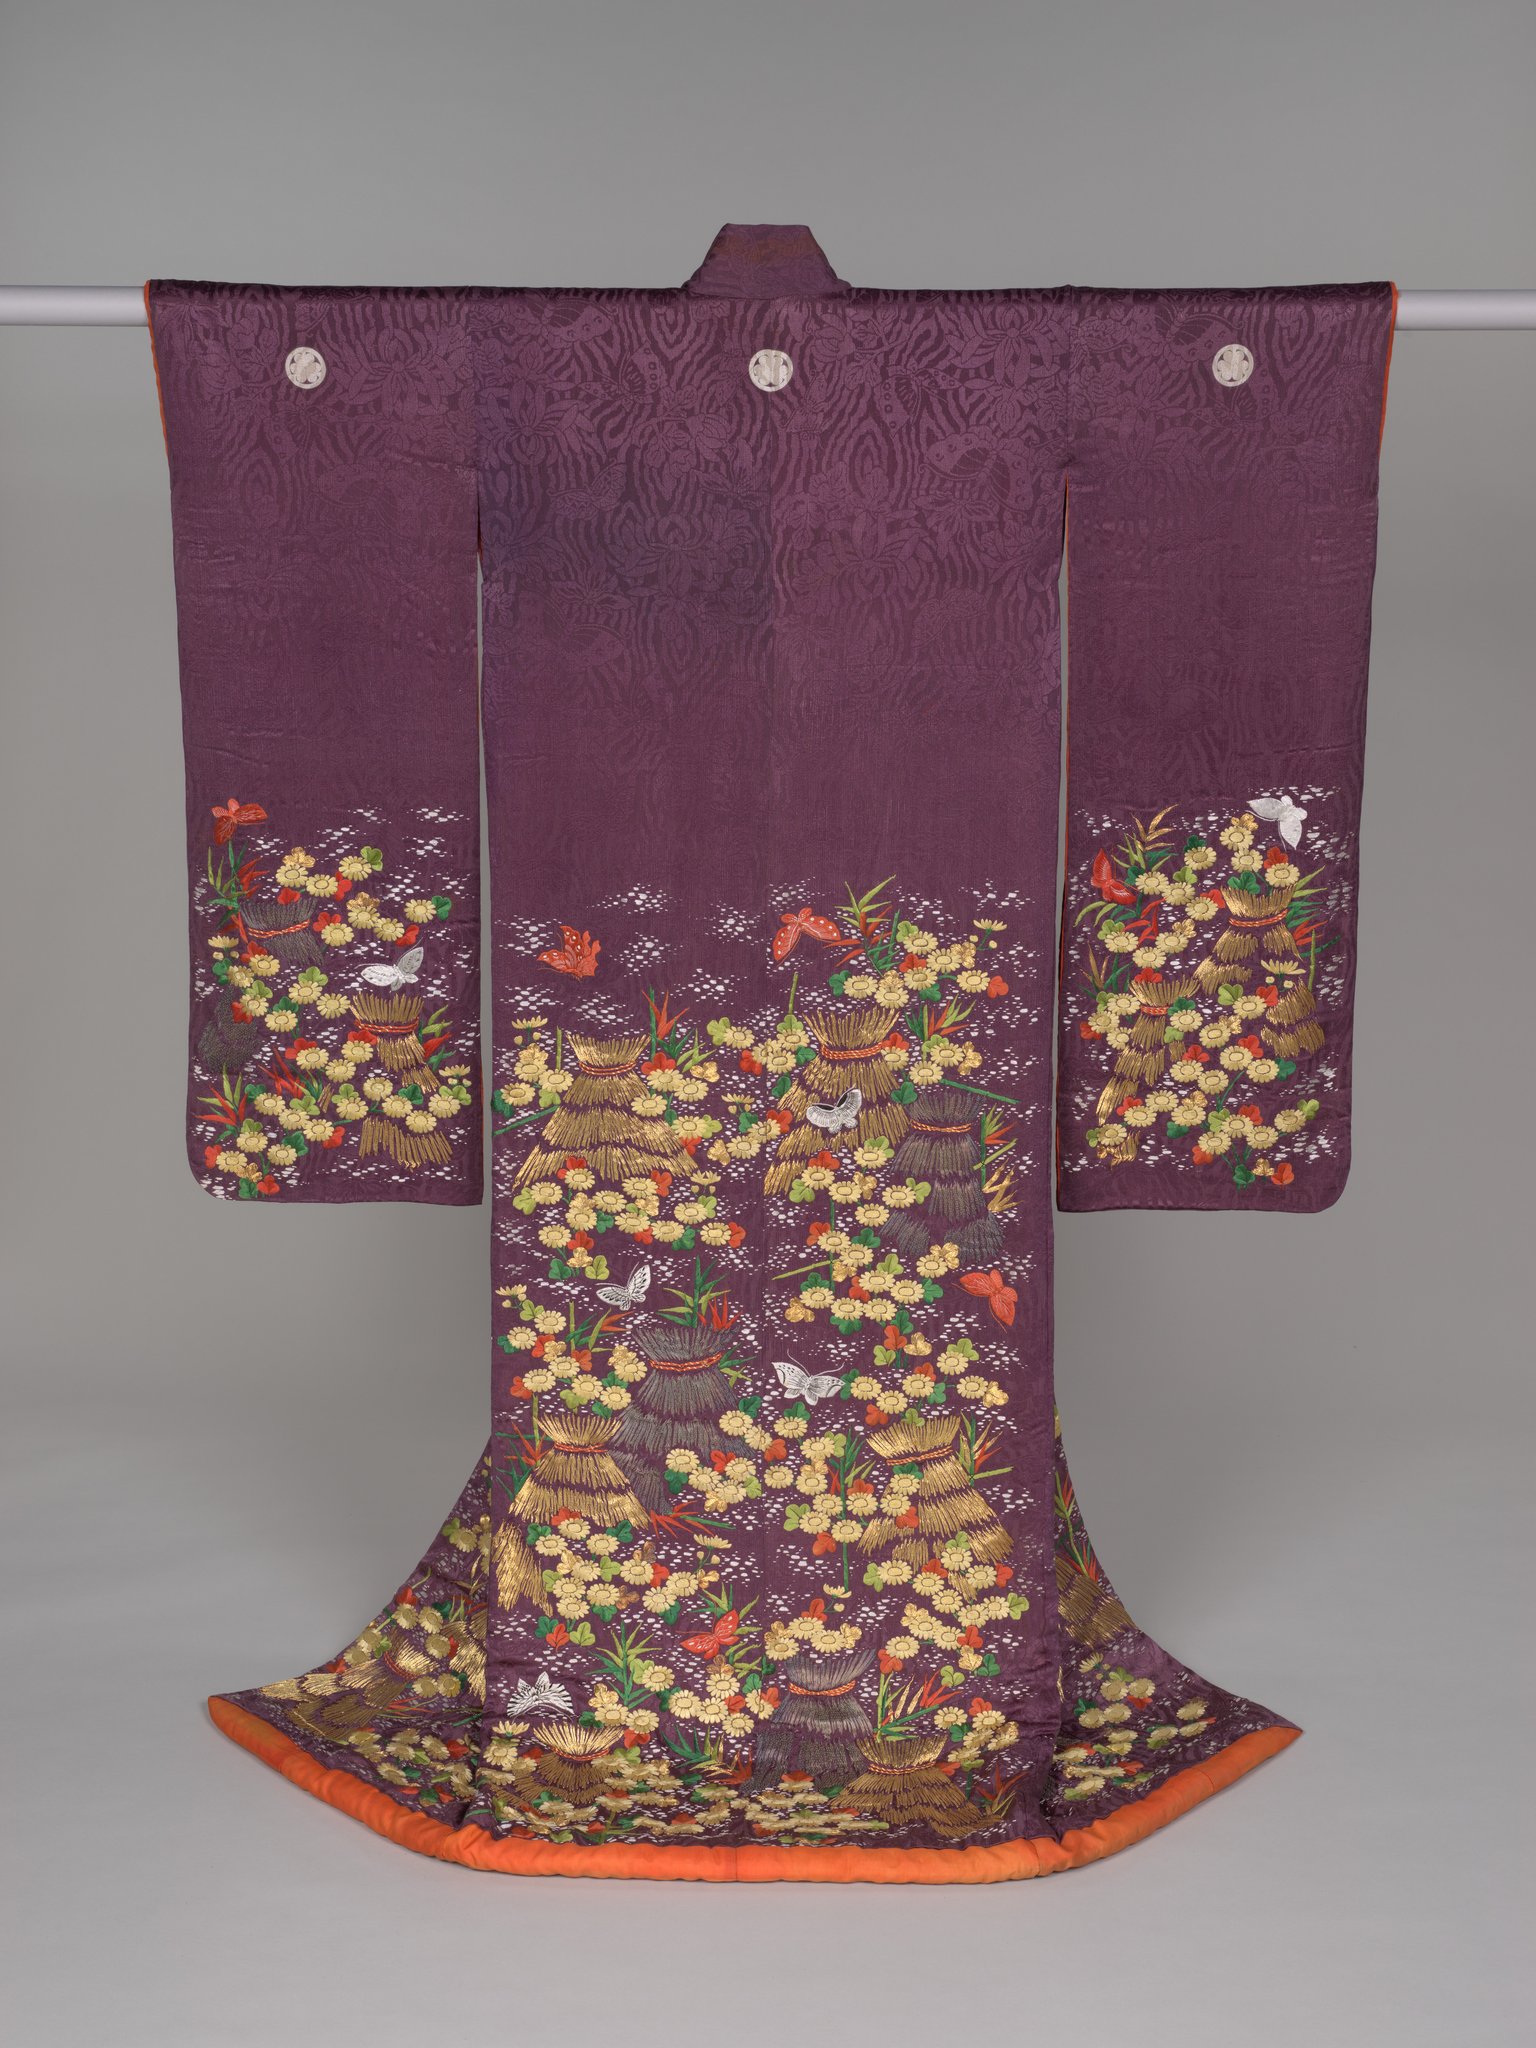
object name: kimono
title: Over robe (uchikake) with chrysanthemums, butterflies, and sheaves of rice straw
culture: japanese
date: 1801-1850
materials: gold thread, paste, silk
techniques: embroidery, resist, satin weave